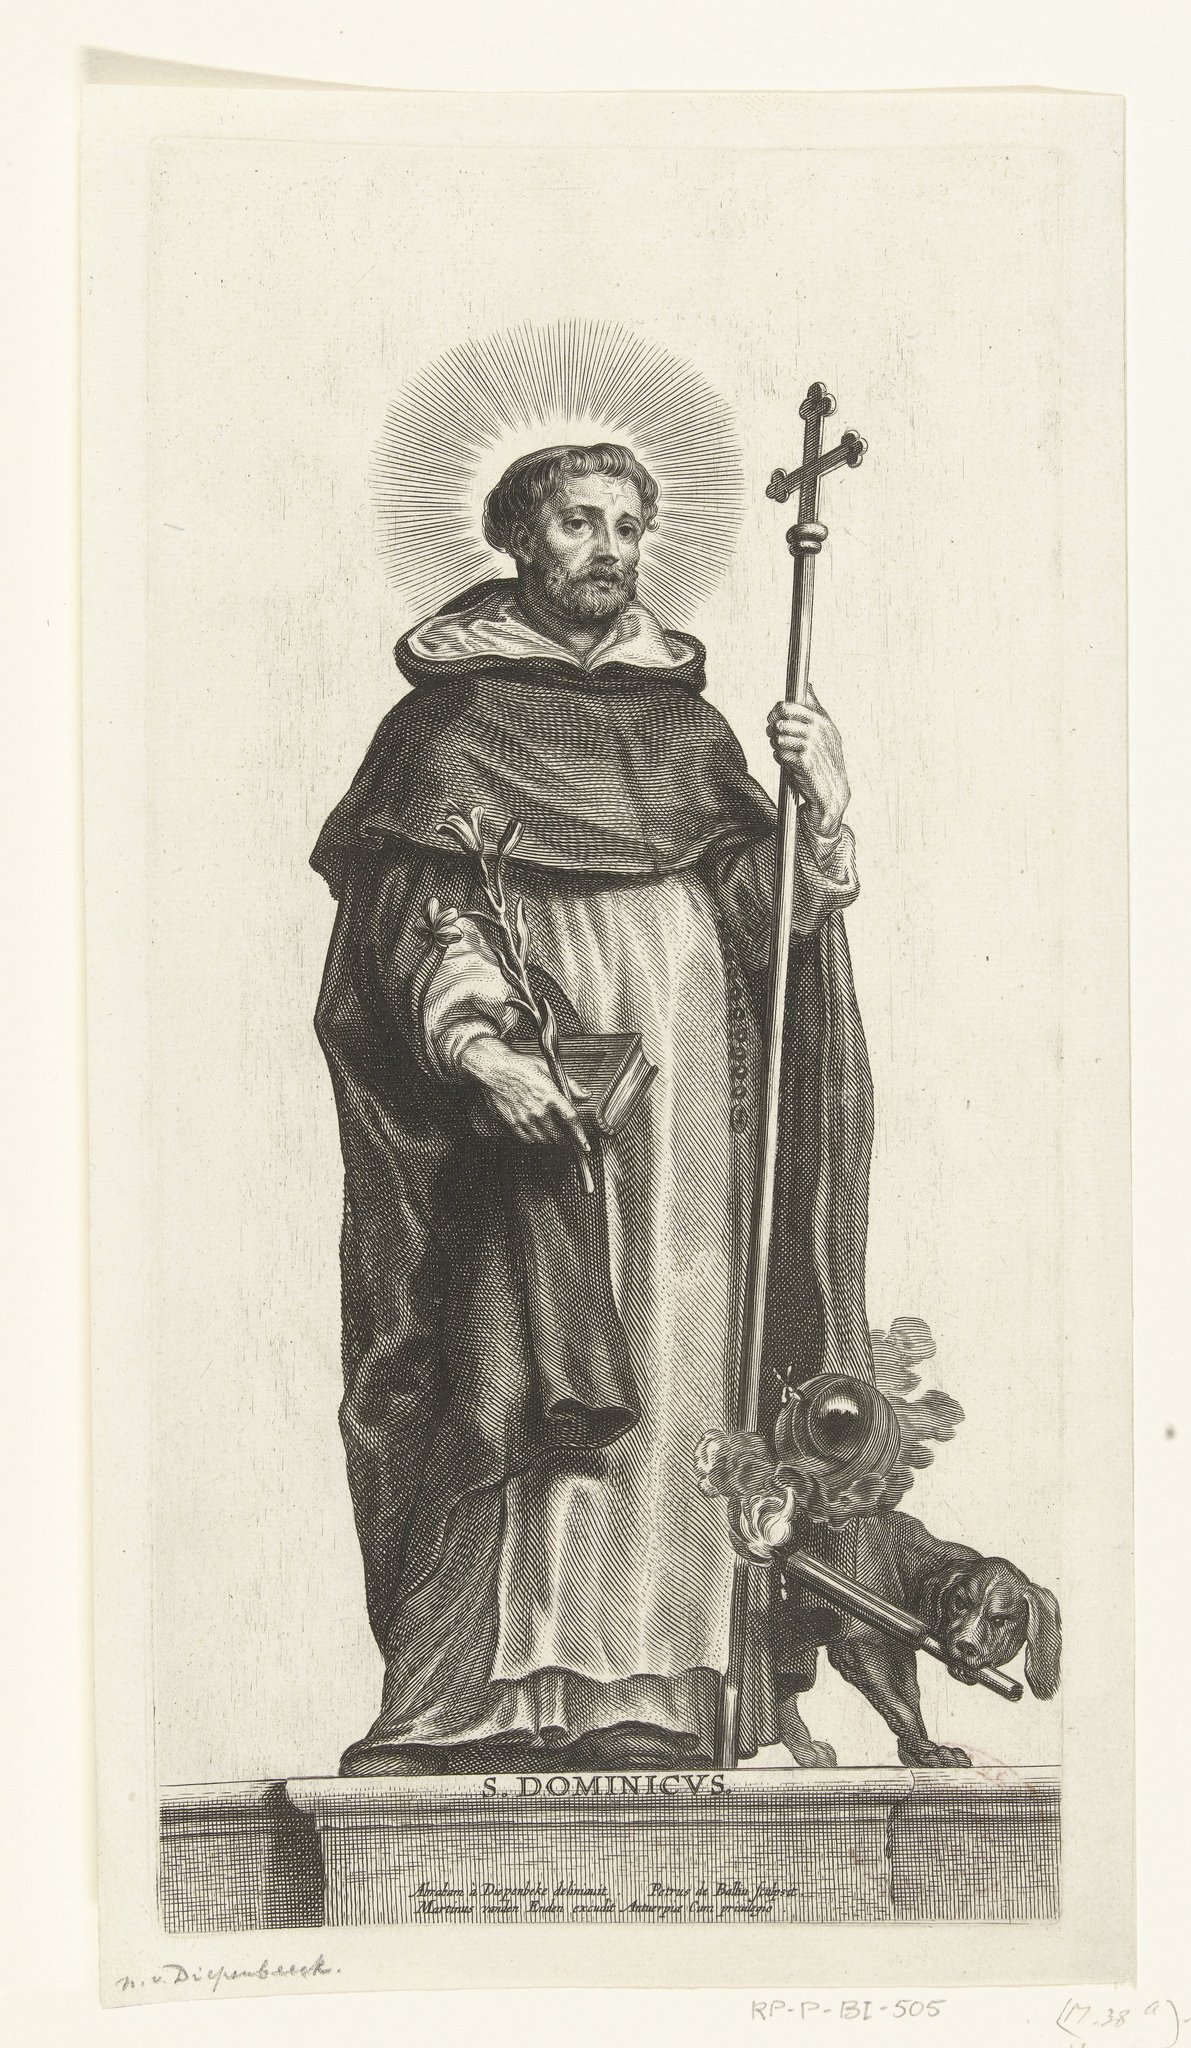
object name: print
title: Heilige Dominicus met rijksappel en hond met brandende fakkel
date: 1623-1660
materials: paper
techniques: engraving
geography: antwerp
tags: dominic(us) guzman of calerueja, founder of the order of preachers (or dominican (black) friars; possible attributes: book, dog with flaming torch, lily, loaf of bread, rosary, star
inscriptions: collector's mark: Lugt 240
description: Prent naar tekening van Abraham van Diepenbeeck.